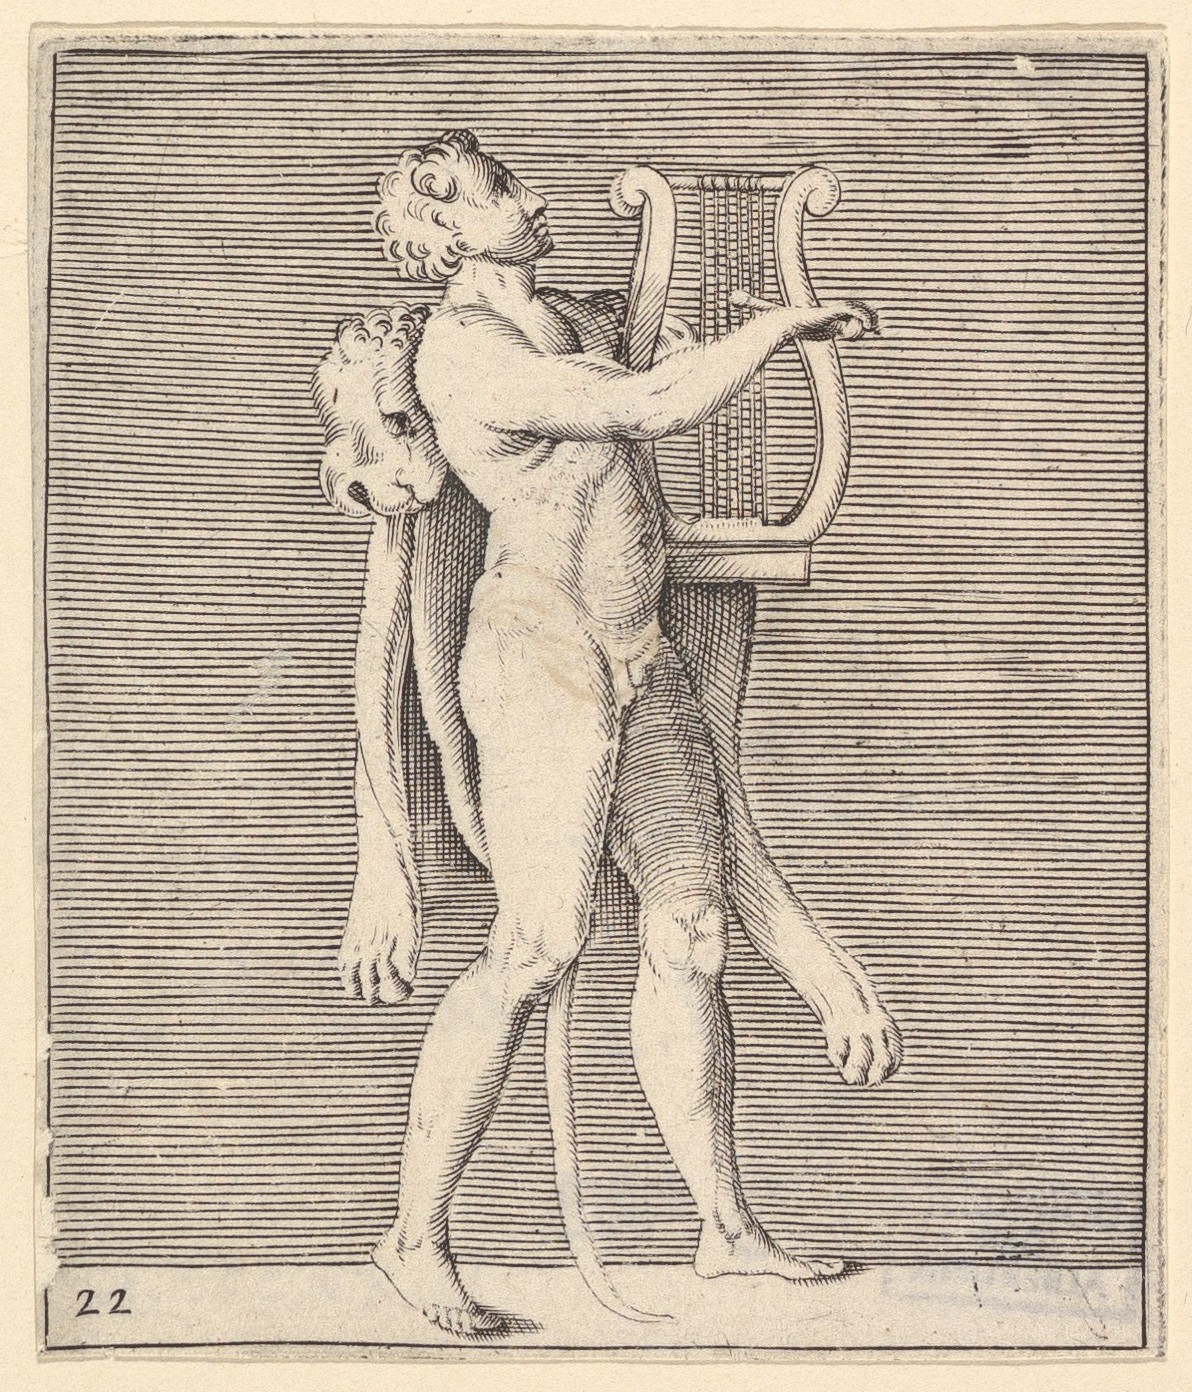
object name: print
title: Hercules playing a lyre, a lionskin draped over his shoulder, from "Ex Antiquis Cameorum et Gemmae Delineata/ Liber Secundus/et ab Enea Vico Parmen Incis"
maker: anonymous, italian, 16th century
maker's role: artist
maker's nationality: italian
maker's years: 1500-1600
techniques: engraving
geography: rome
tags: harps,hercules